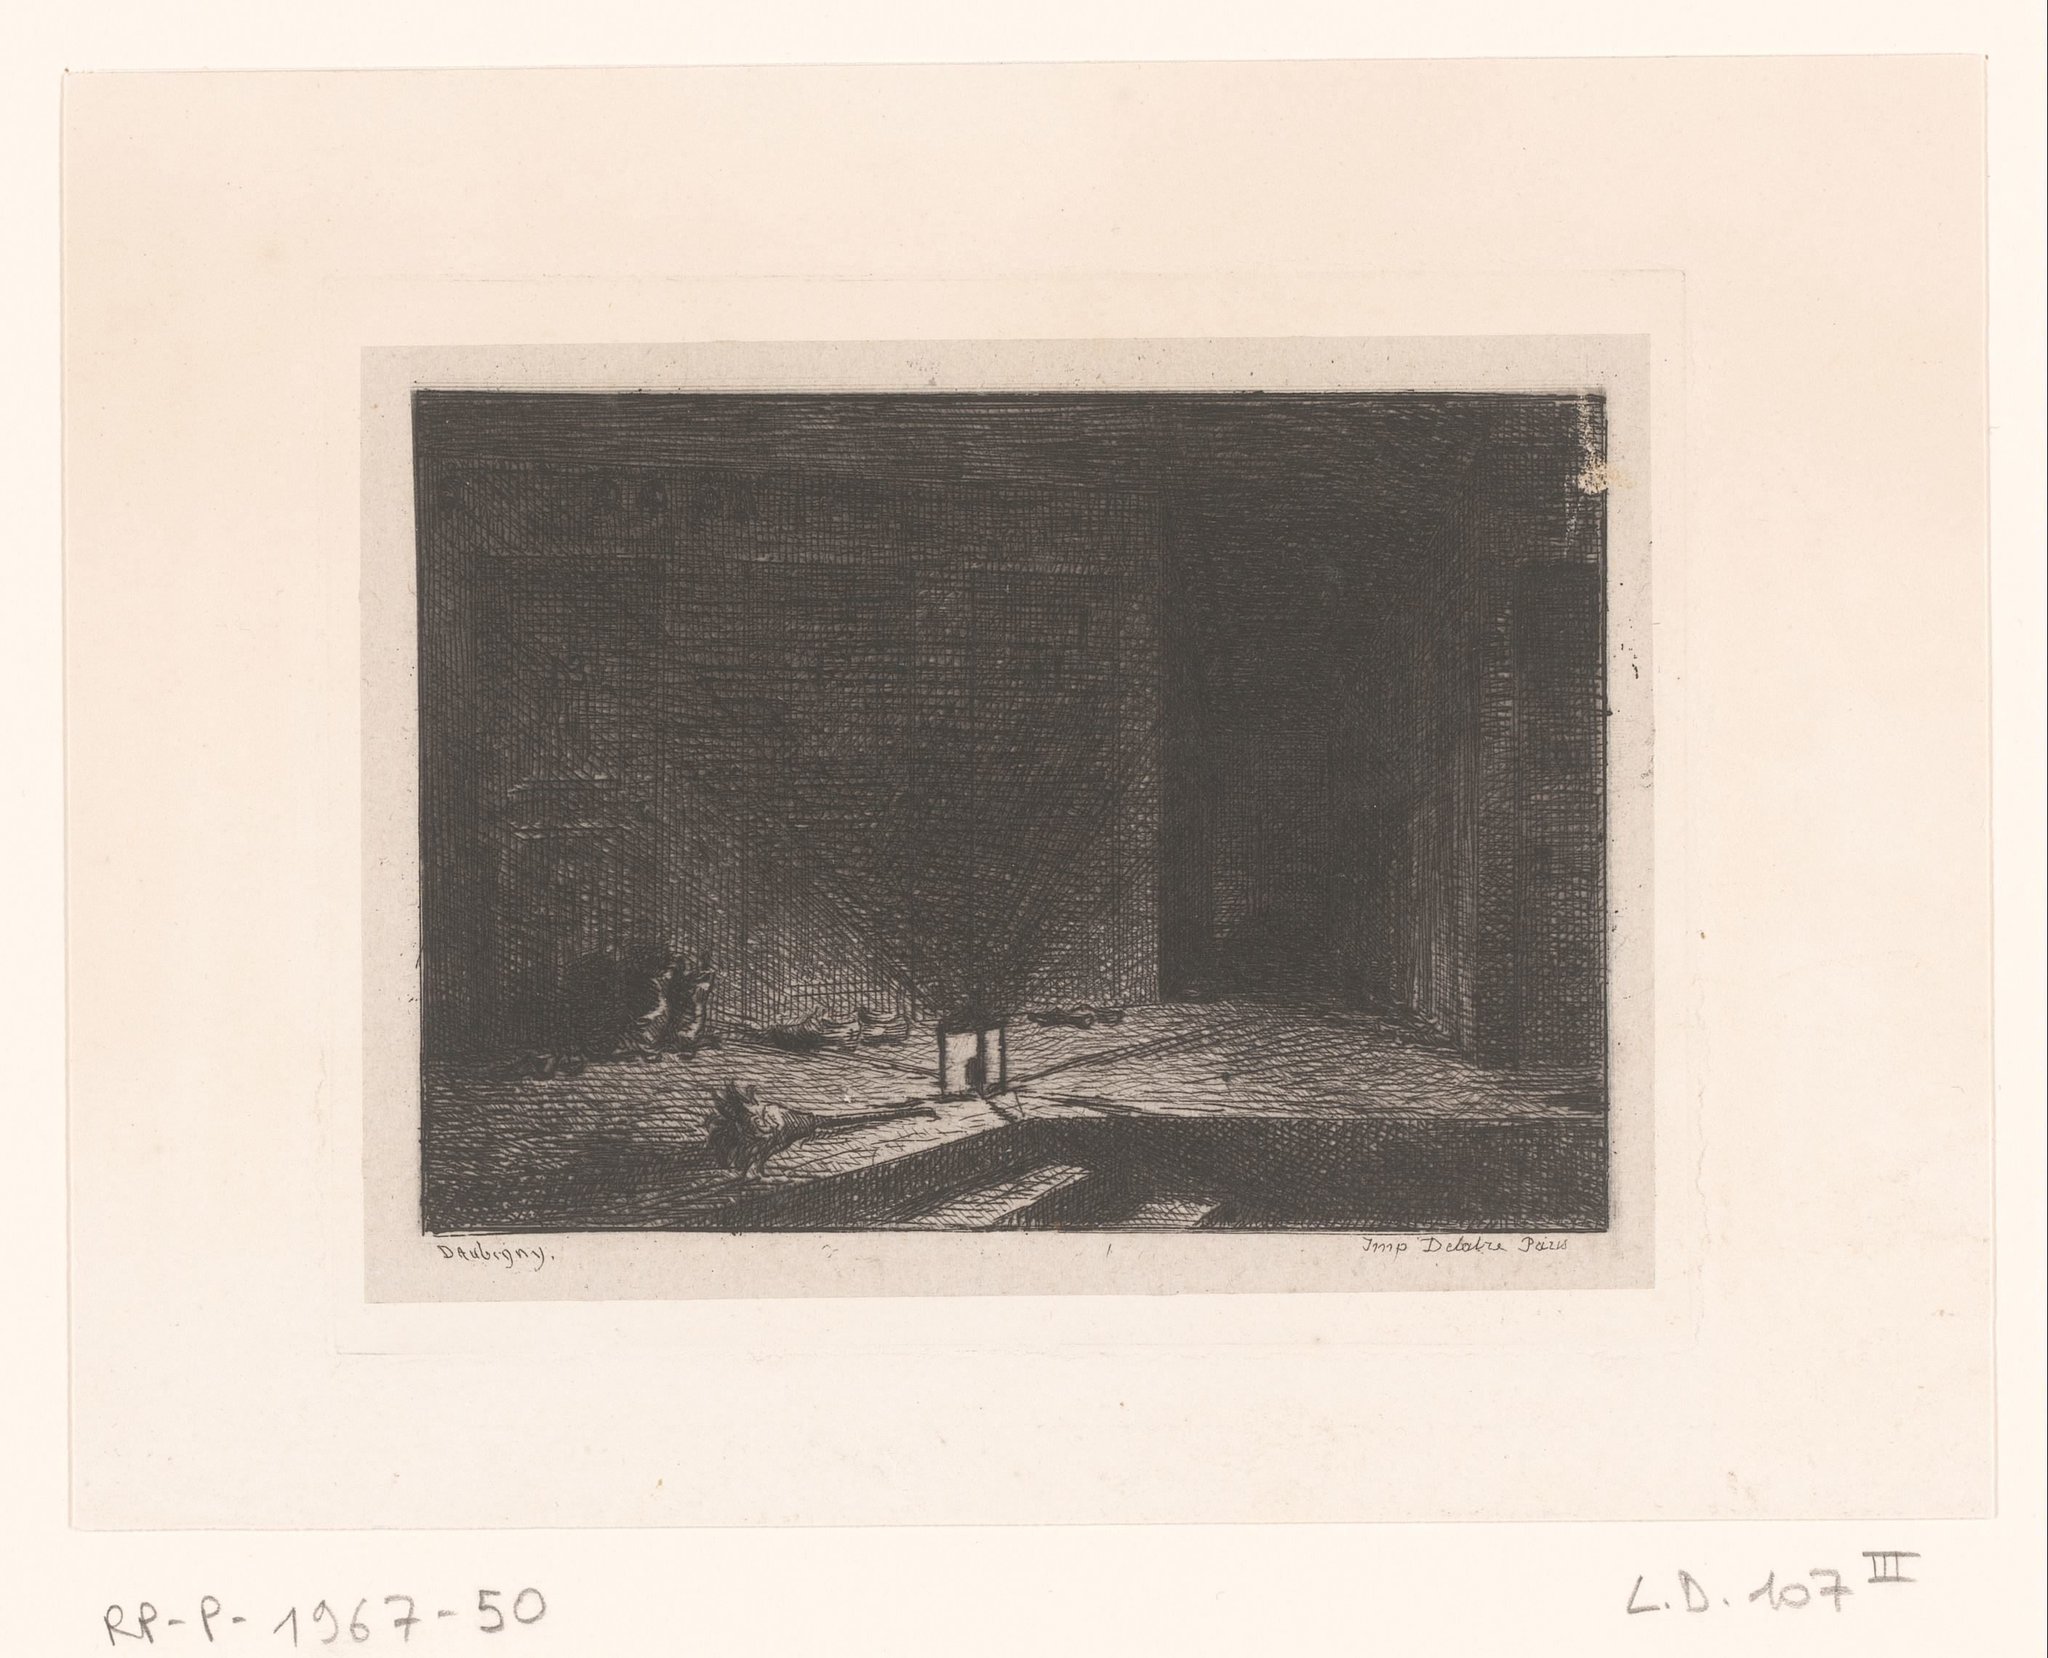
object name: print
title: Serie met landschappen en gebeurtenissen rond water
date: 1867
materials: paper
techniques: drypoint, engraving, etching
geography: paris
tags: interior of the house, lantern, (household) utensils and implements (with name)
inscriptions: collector's mark: Lugt 2760, collector's mark: Lugt 2228